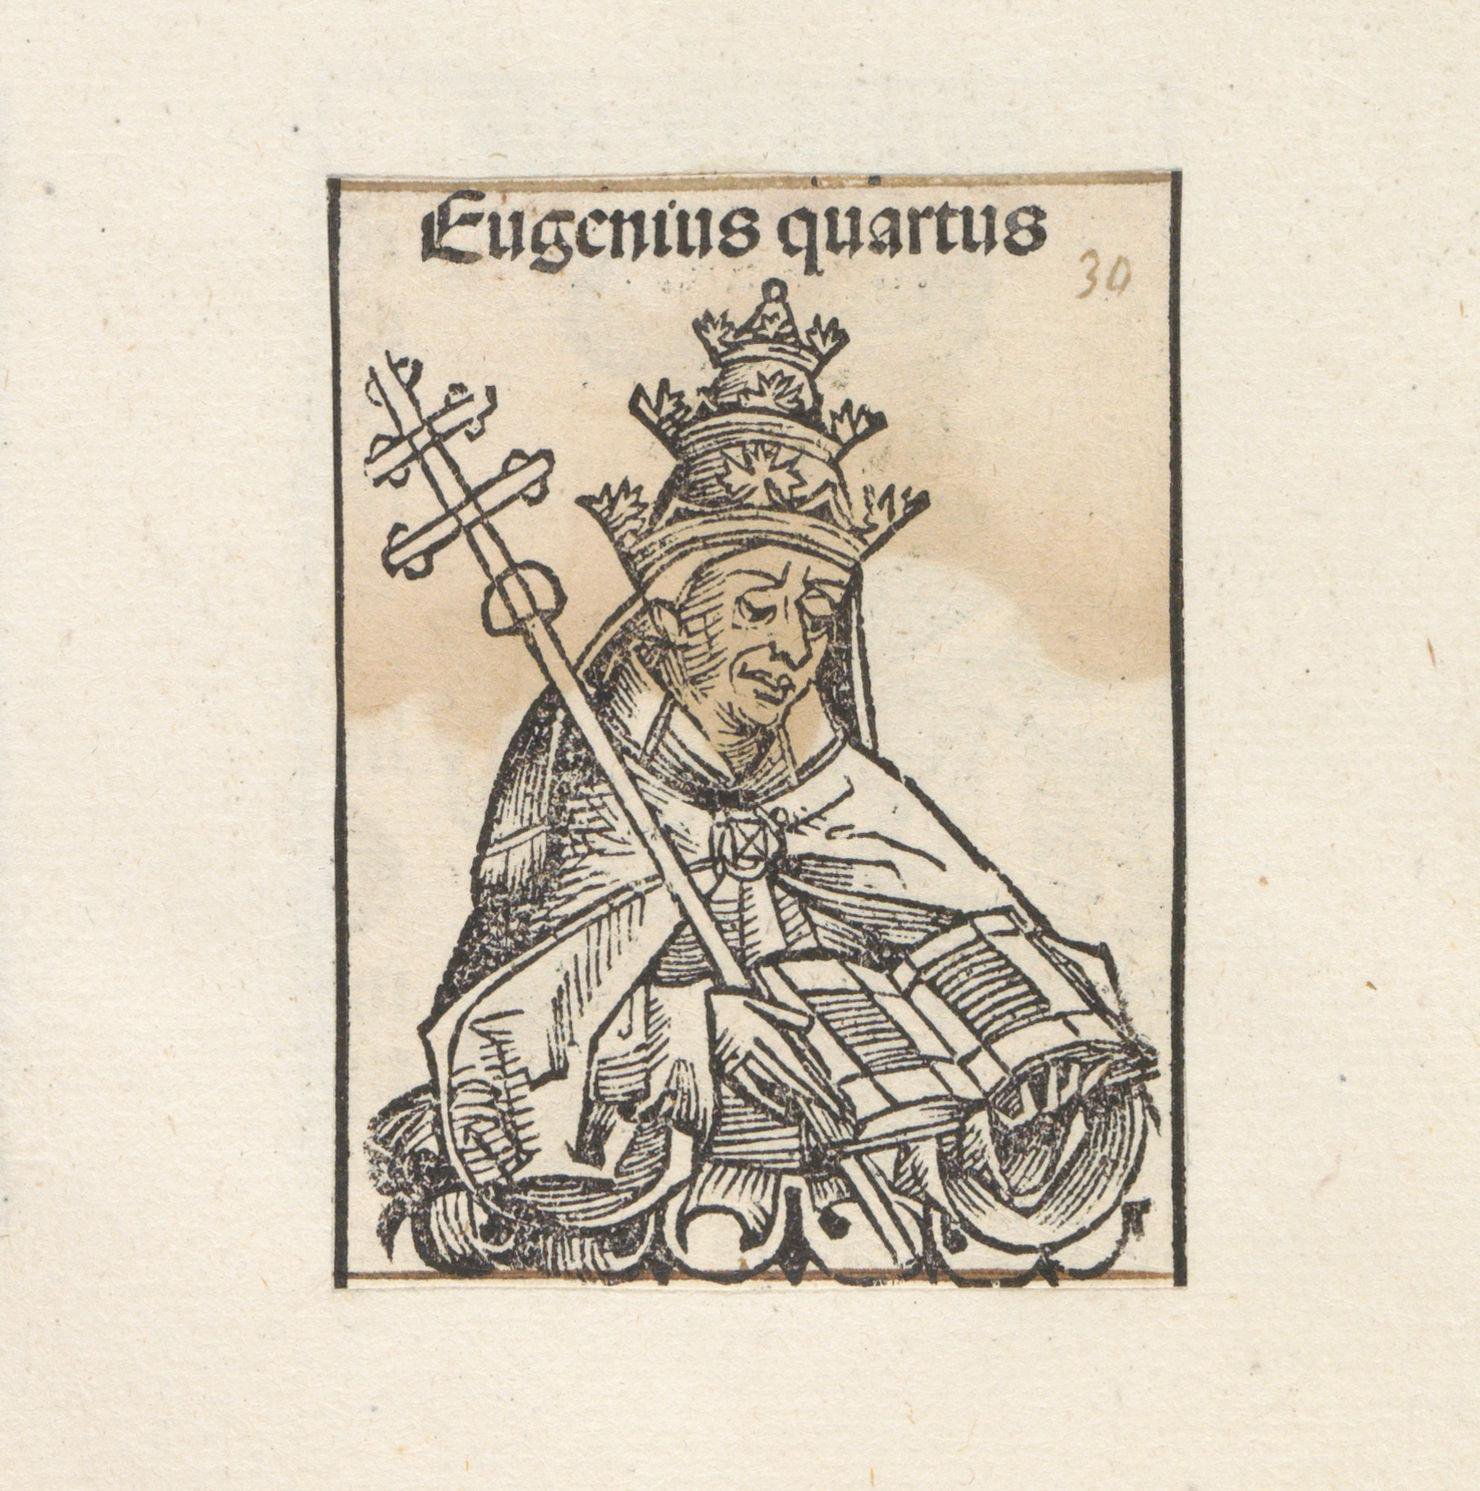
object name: book illustration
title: Eugenius quartus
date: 1493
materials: paper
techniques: letterpress printing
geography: nuremberg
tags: venice, rome, pope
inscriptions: inscription: ‘30’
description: Een bloemkelk met een paus. Hij draagt een tiara en heeft een opengeslagen bijbel en een staf met een dubbel kruis in zijn handen. De voorstelling is onderdeel van de opeenvolging pausen in de Liber Chronicarum. De tekst identificeert de man als paus Eugenius IV. De prent maakt deel uit van een album.